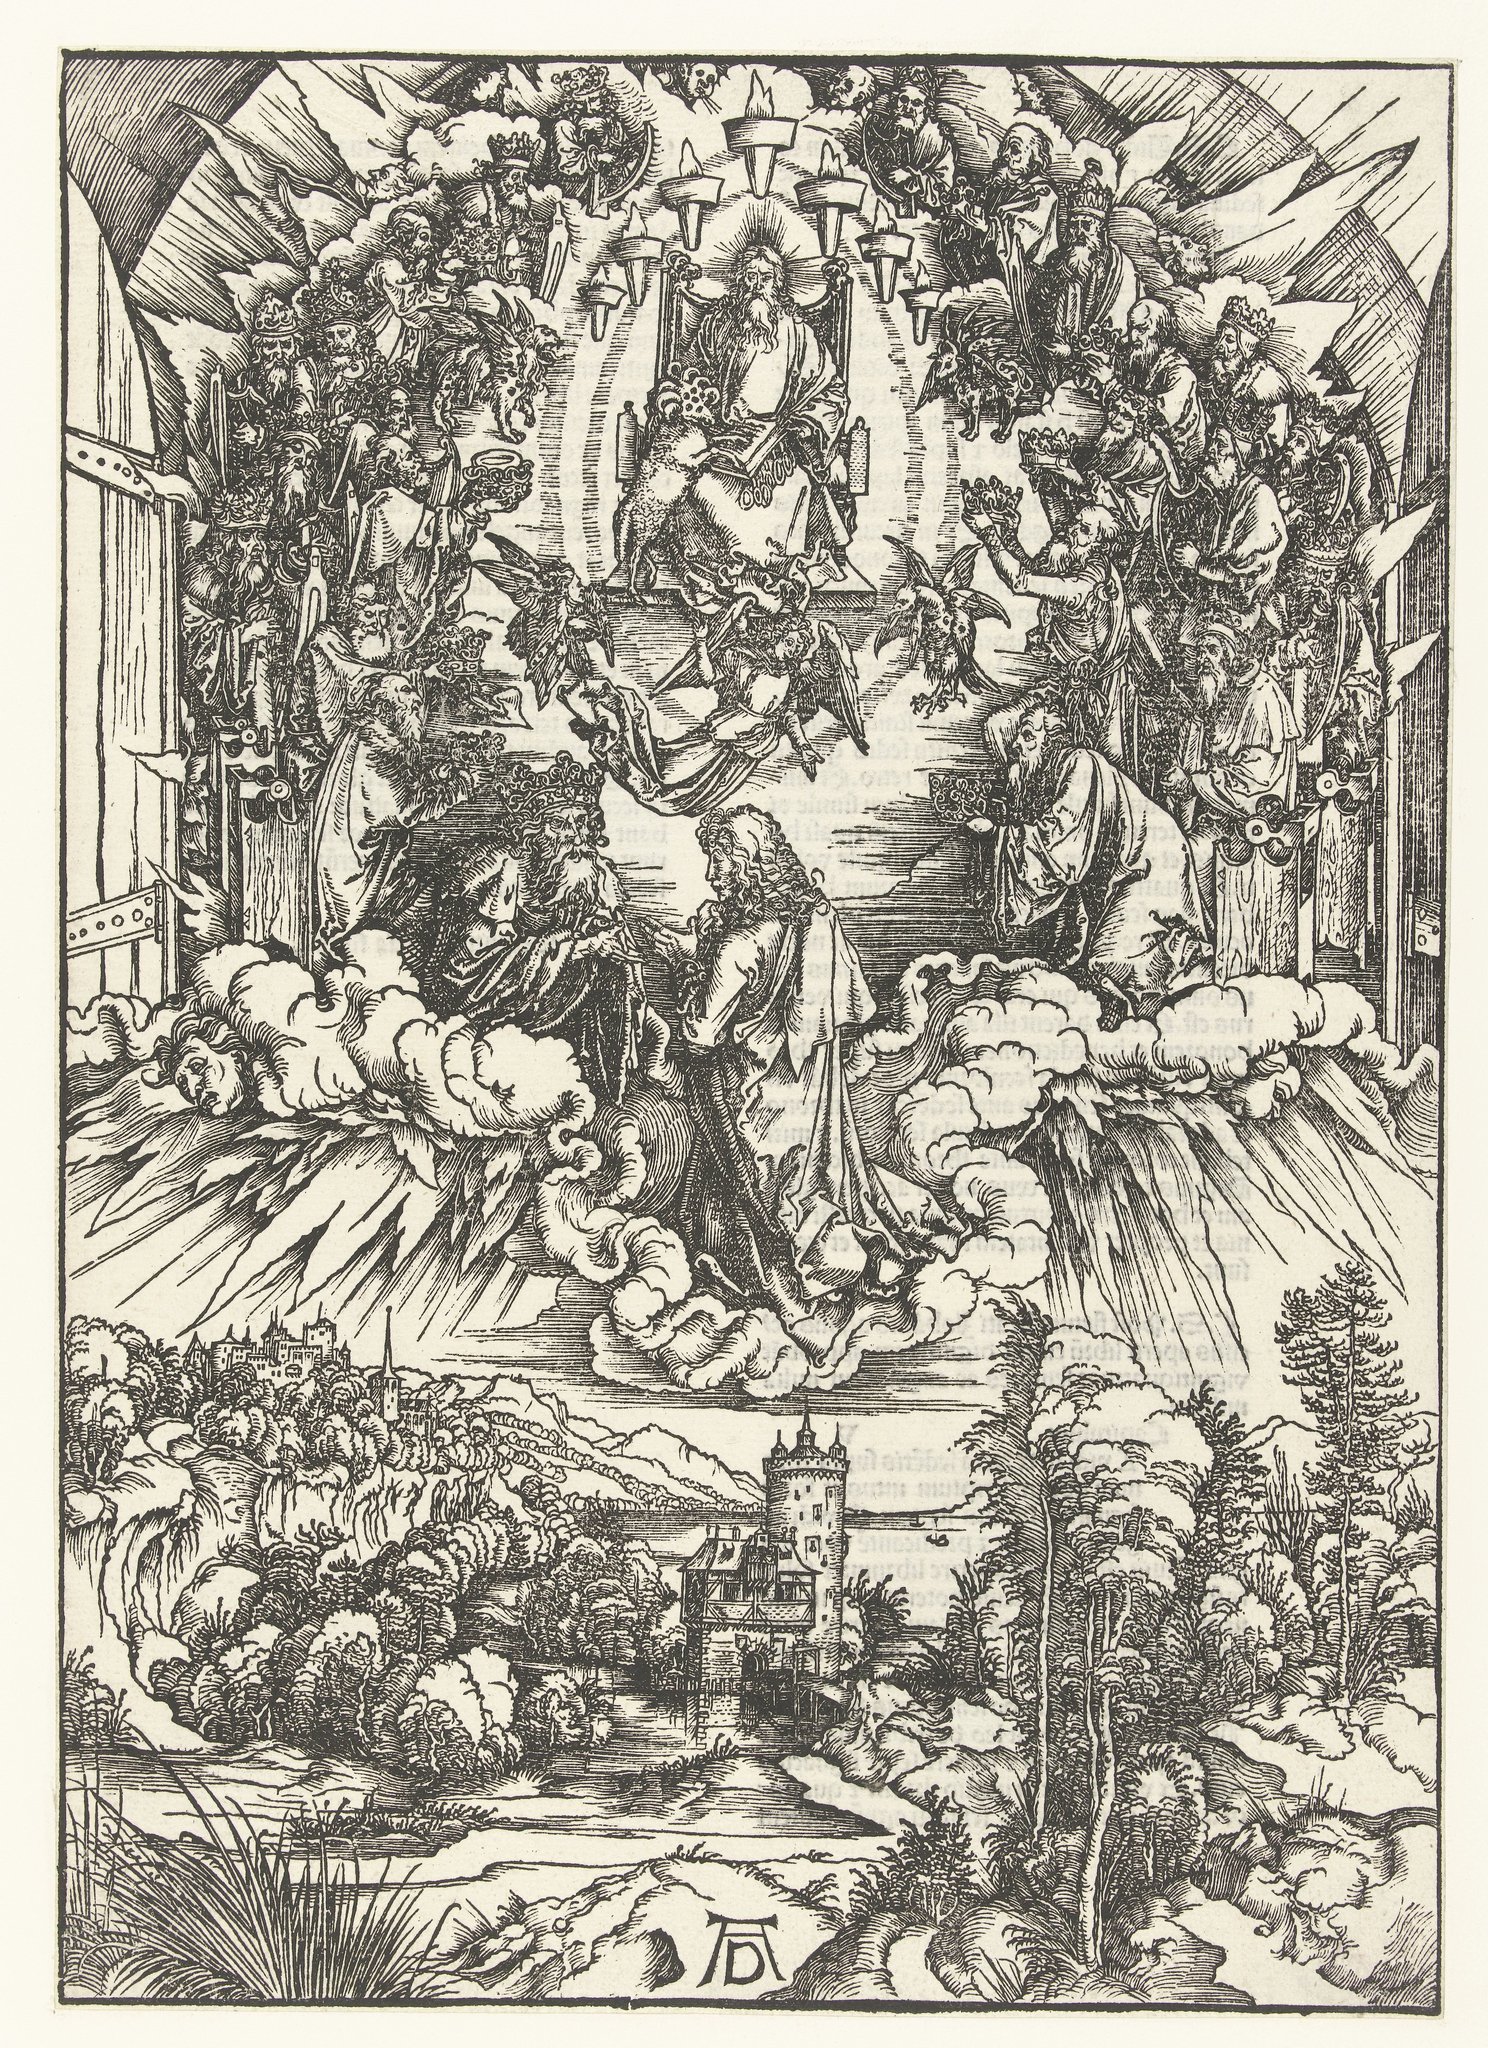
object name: print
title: Johannes de Evangelist knielt voor Christus en het lam met de zeven hoorns en de zeven ogen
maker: albrecht dürer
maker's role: draughtsman, painter, print maker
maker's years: 1471-1528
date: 1496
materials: paper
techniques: letterpress printing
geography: nuremberg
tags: the lamb takes the book from him who sits on the throne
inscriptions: collector's mark: Lugt 240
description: Johannes knielt voor Christus, die troont onder zeven toortsen, omgeven door de vier apocalyptische dieren (gevleugelde leeuw, gevleugeld rund, adelaar en engel) en de 24 oudsten. Een lam met zeven hoorns en zeven ogen staat met de voorpoten op een boek met zeven zegels op Christus' schoot. Op versozijde Latijnse bijbeltekst in gotisch schrift in twee kolommen.